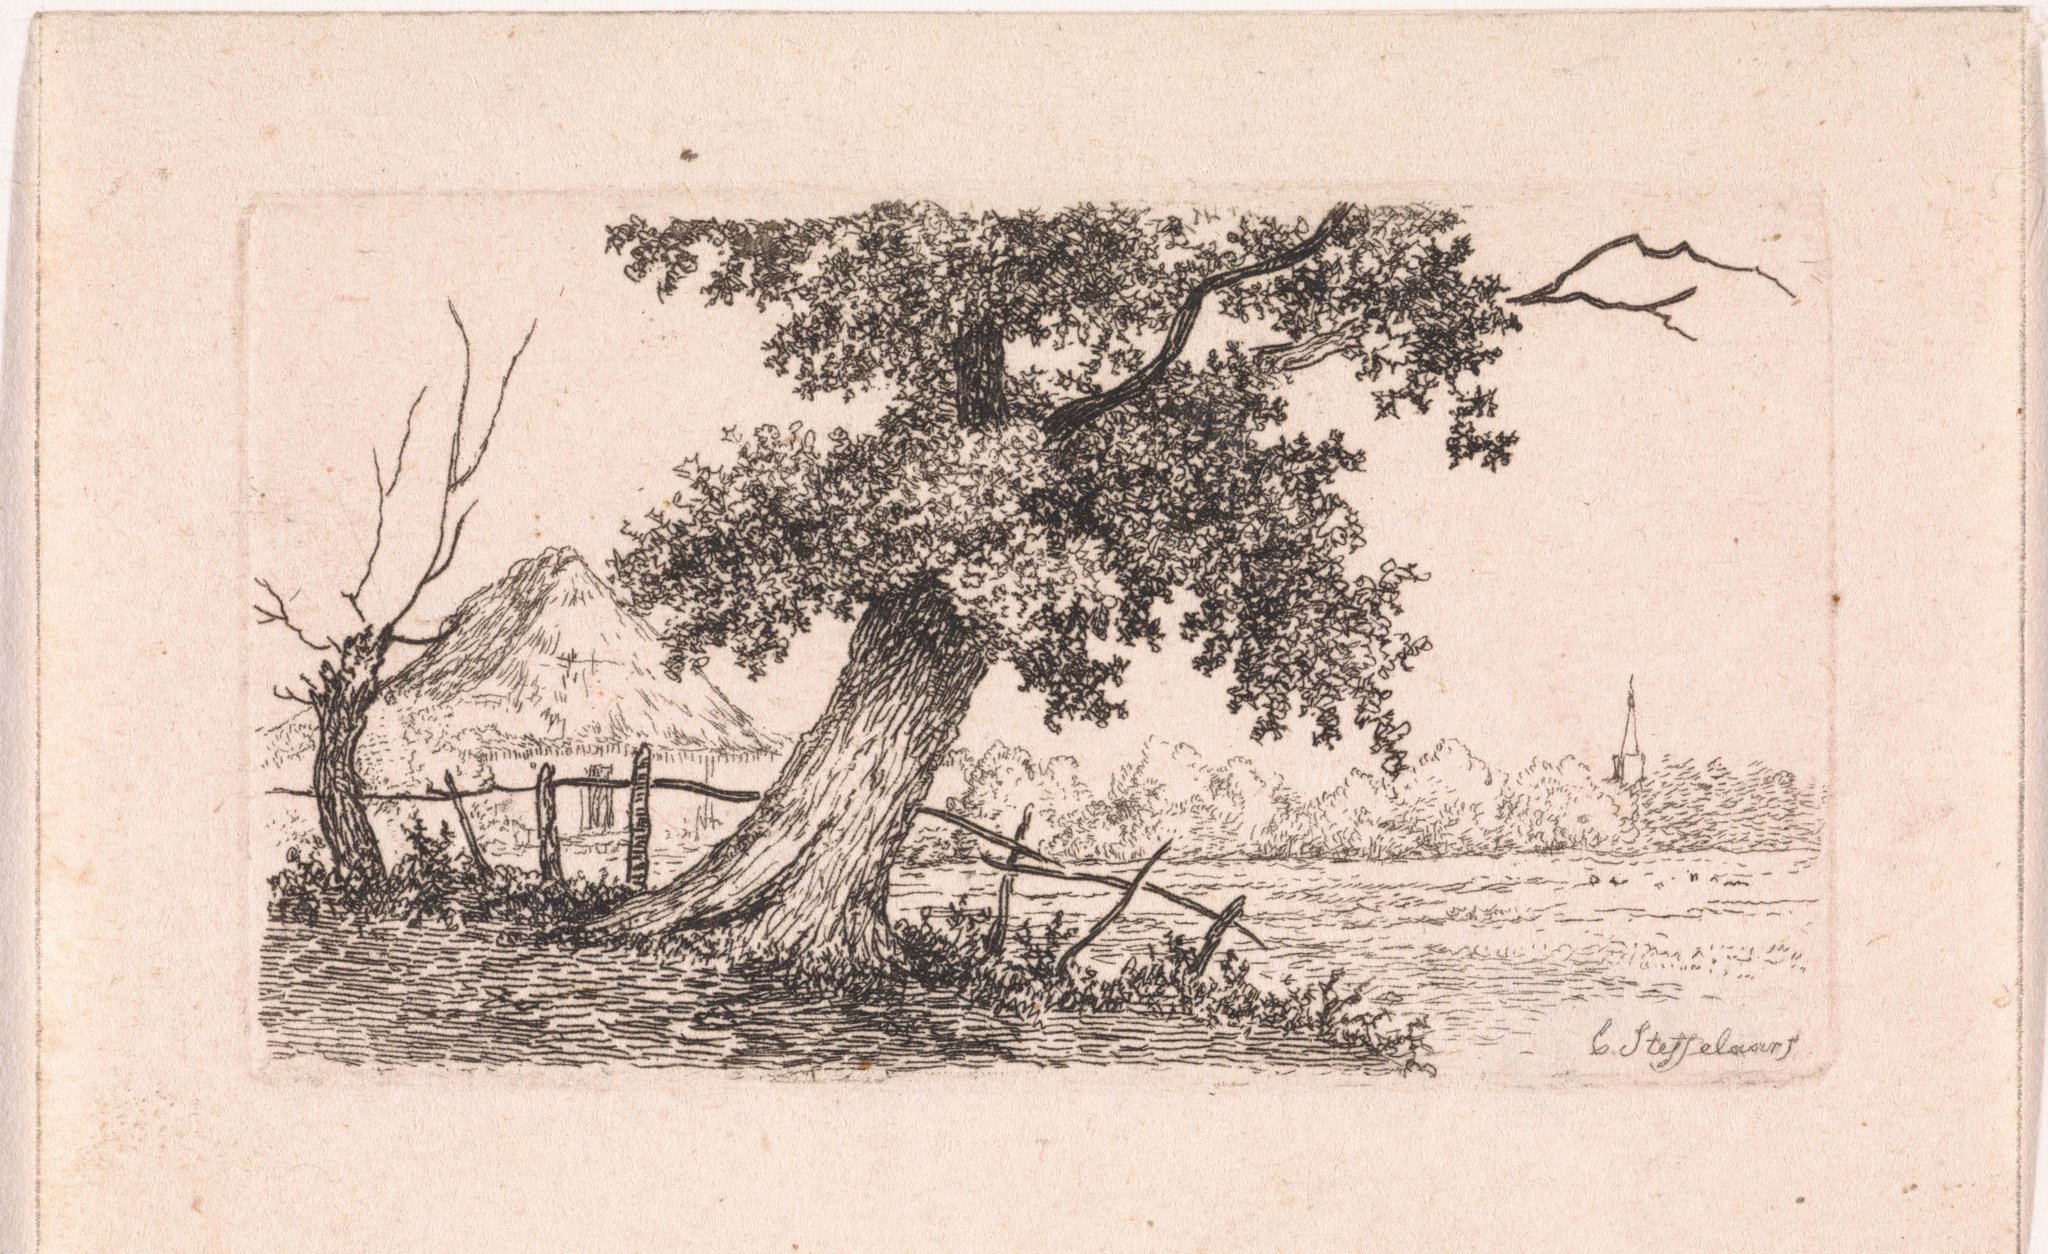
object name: print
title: Tweede suite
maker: cornelis steffelaar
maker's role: draughtsman, painter, print maker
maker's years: 1797-1861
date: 1845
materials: paper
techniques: etching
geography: amsterdam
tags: trees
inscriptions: collector's mark: Lugt 2227